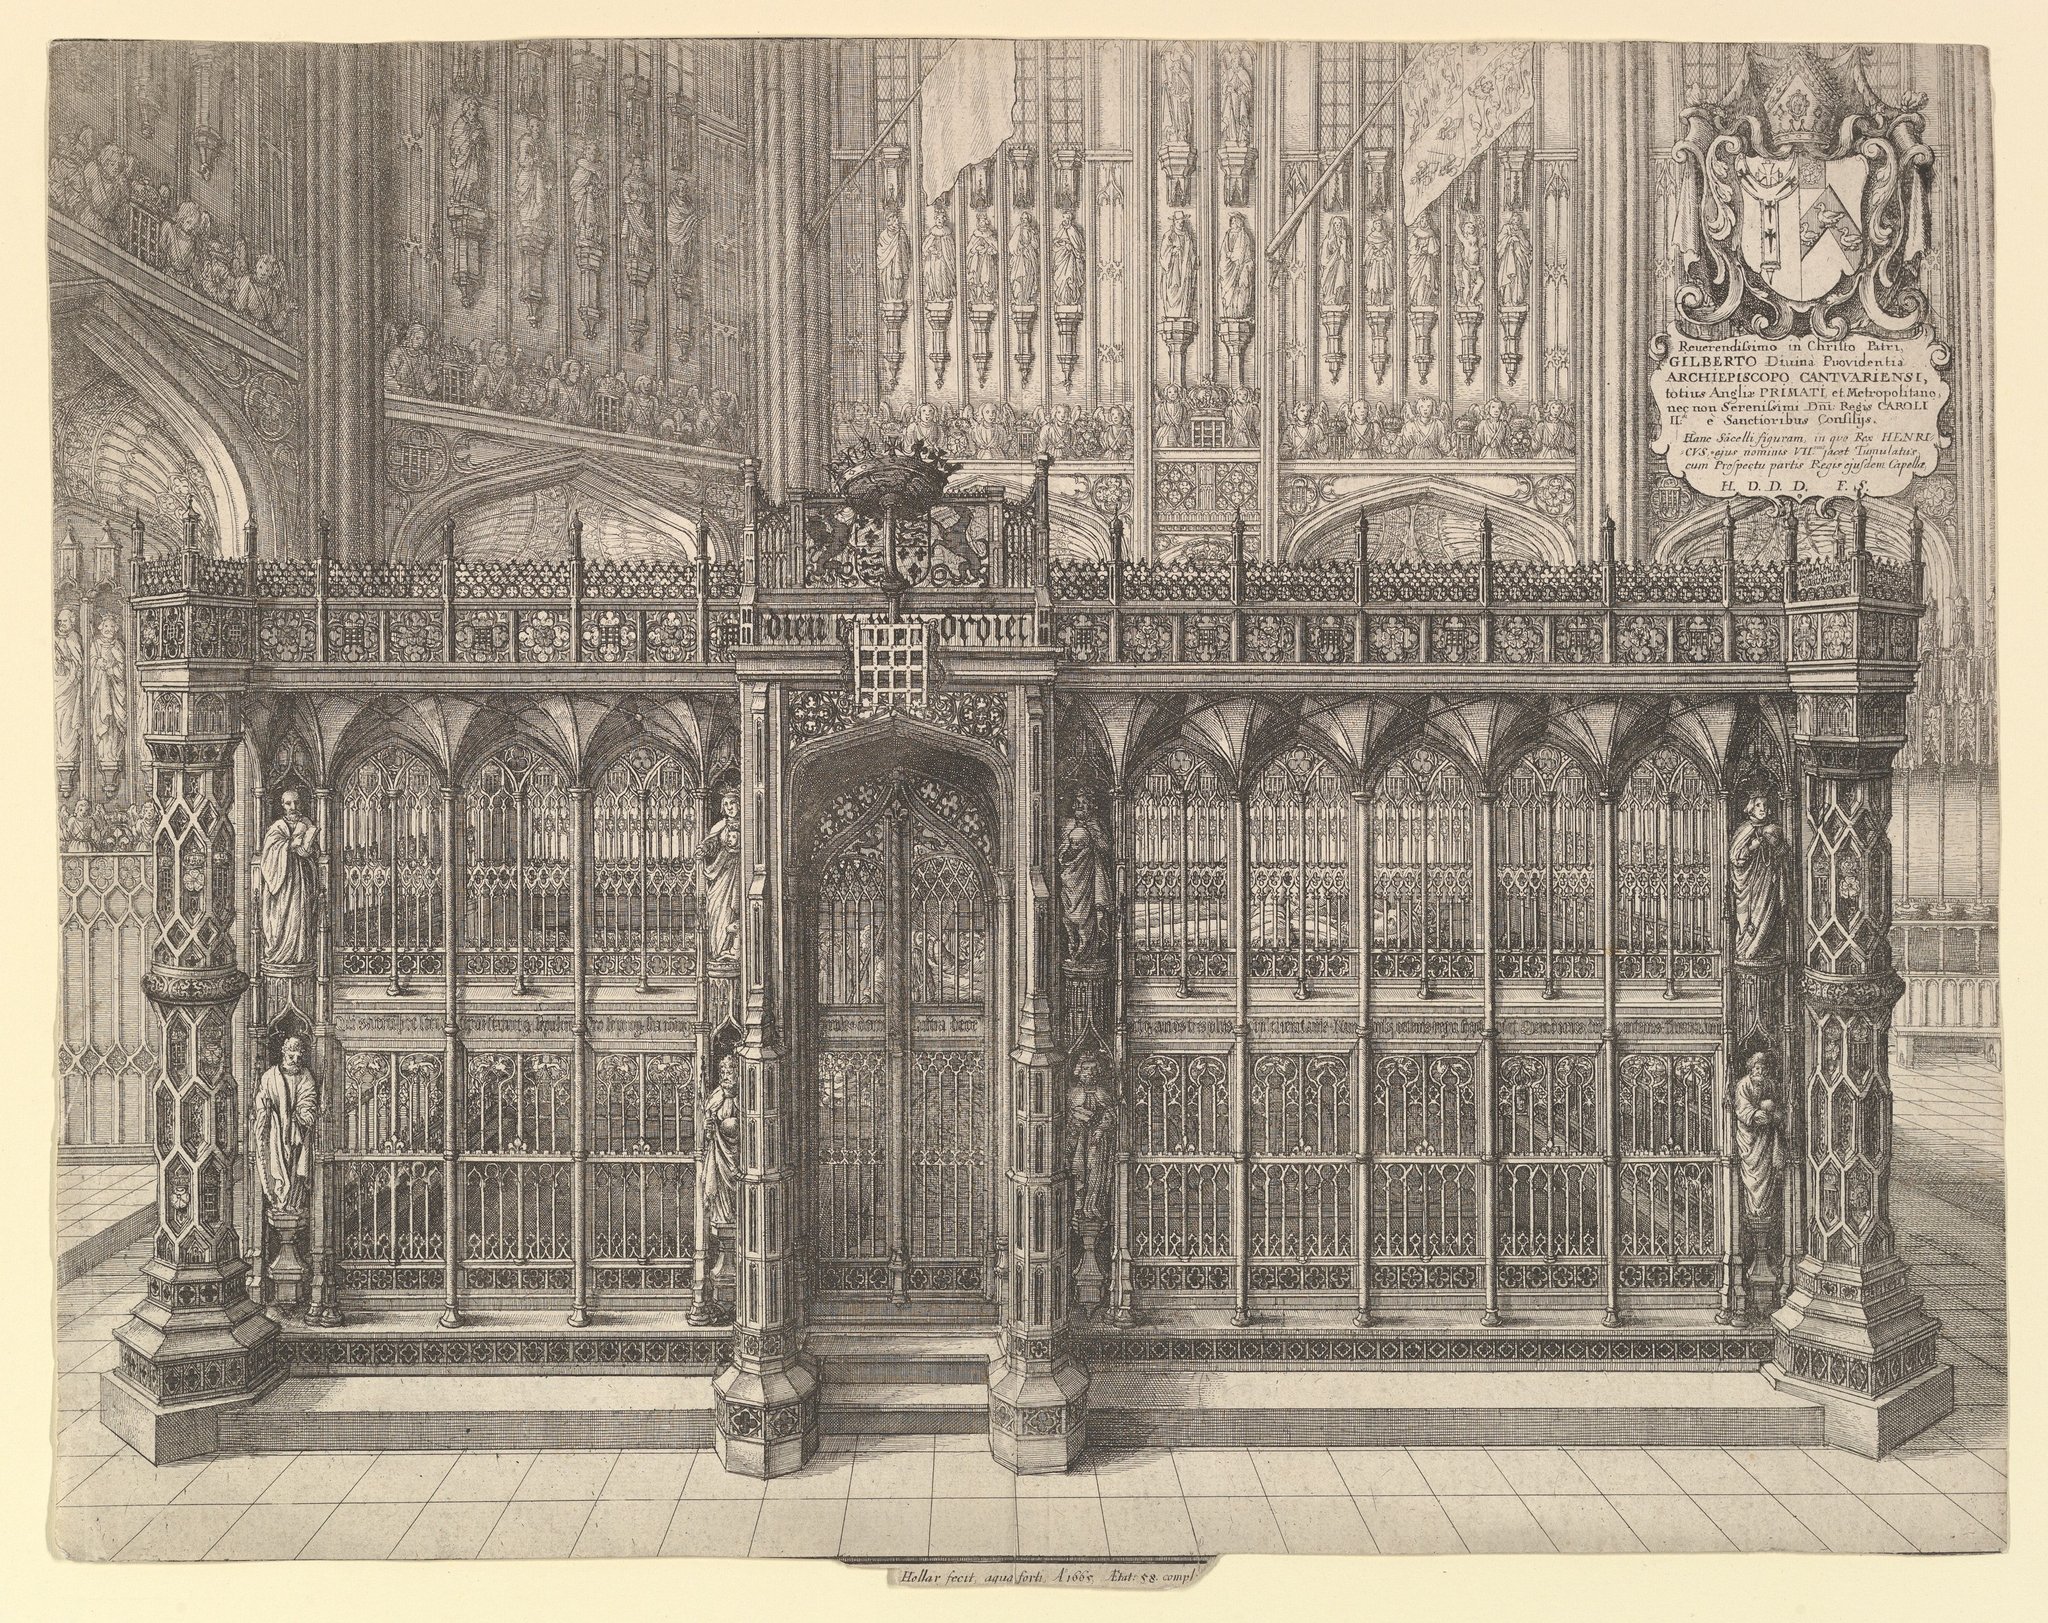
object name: print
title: Tomb of Henry VII (from Francis Sandford, "Genealogical History of the Kings of England,"1677)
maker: wenceslaus hollar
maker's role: artist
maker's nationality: bohemian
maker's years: 1607-1677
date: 1665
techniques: etching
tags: tombs,interiors,coat of arms